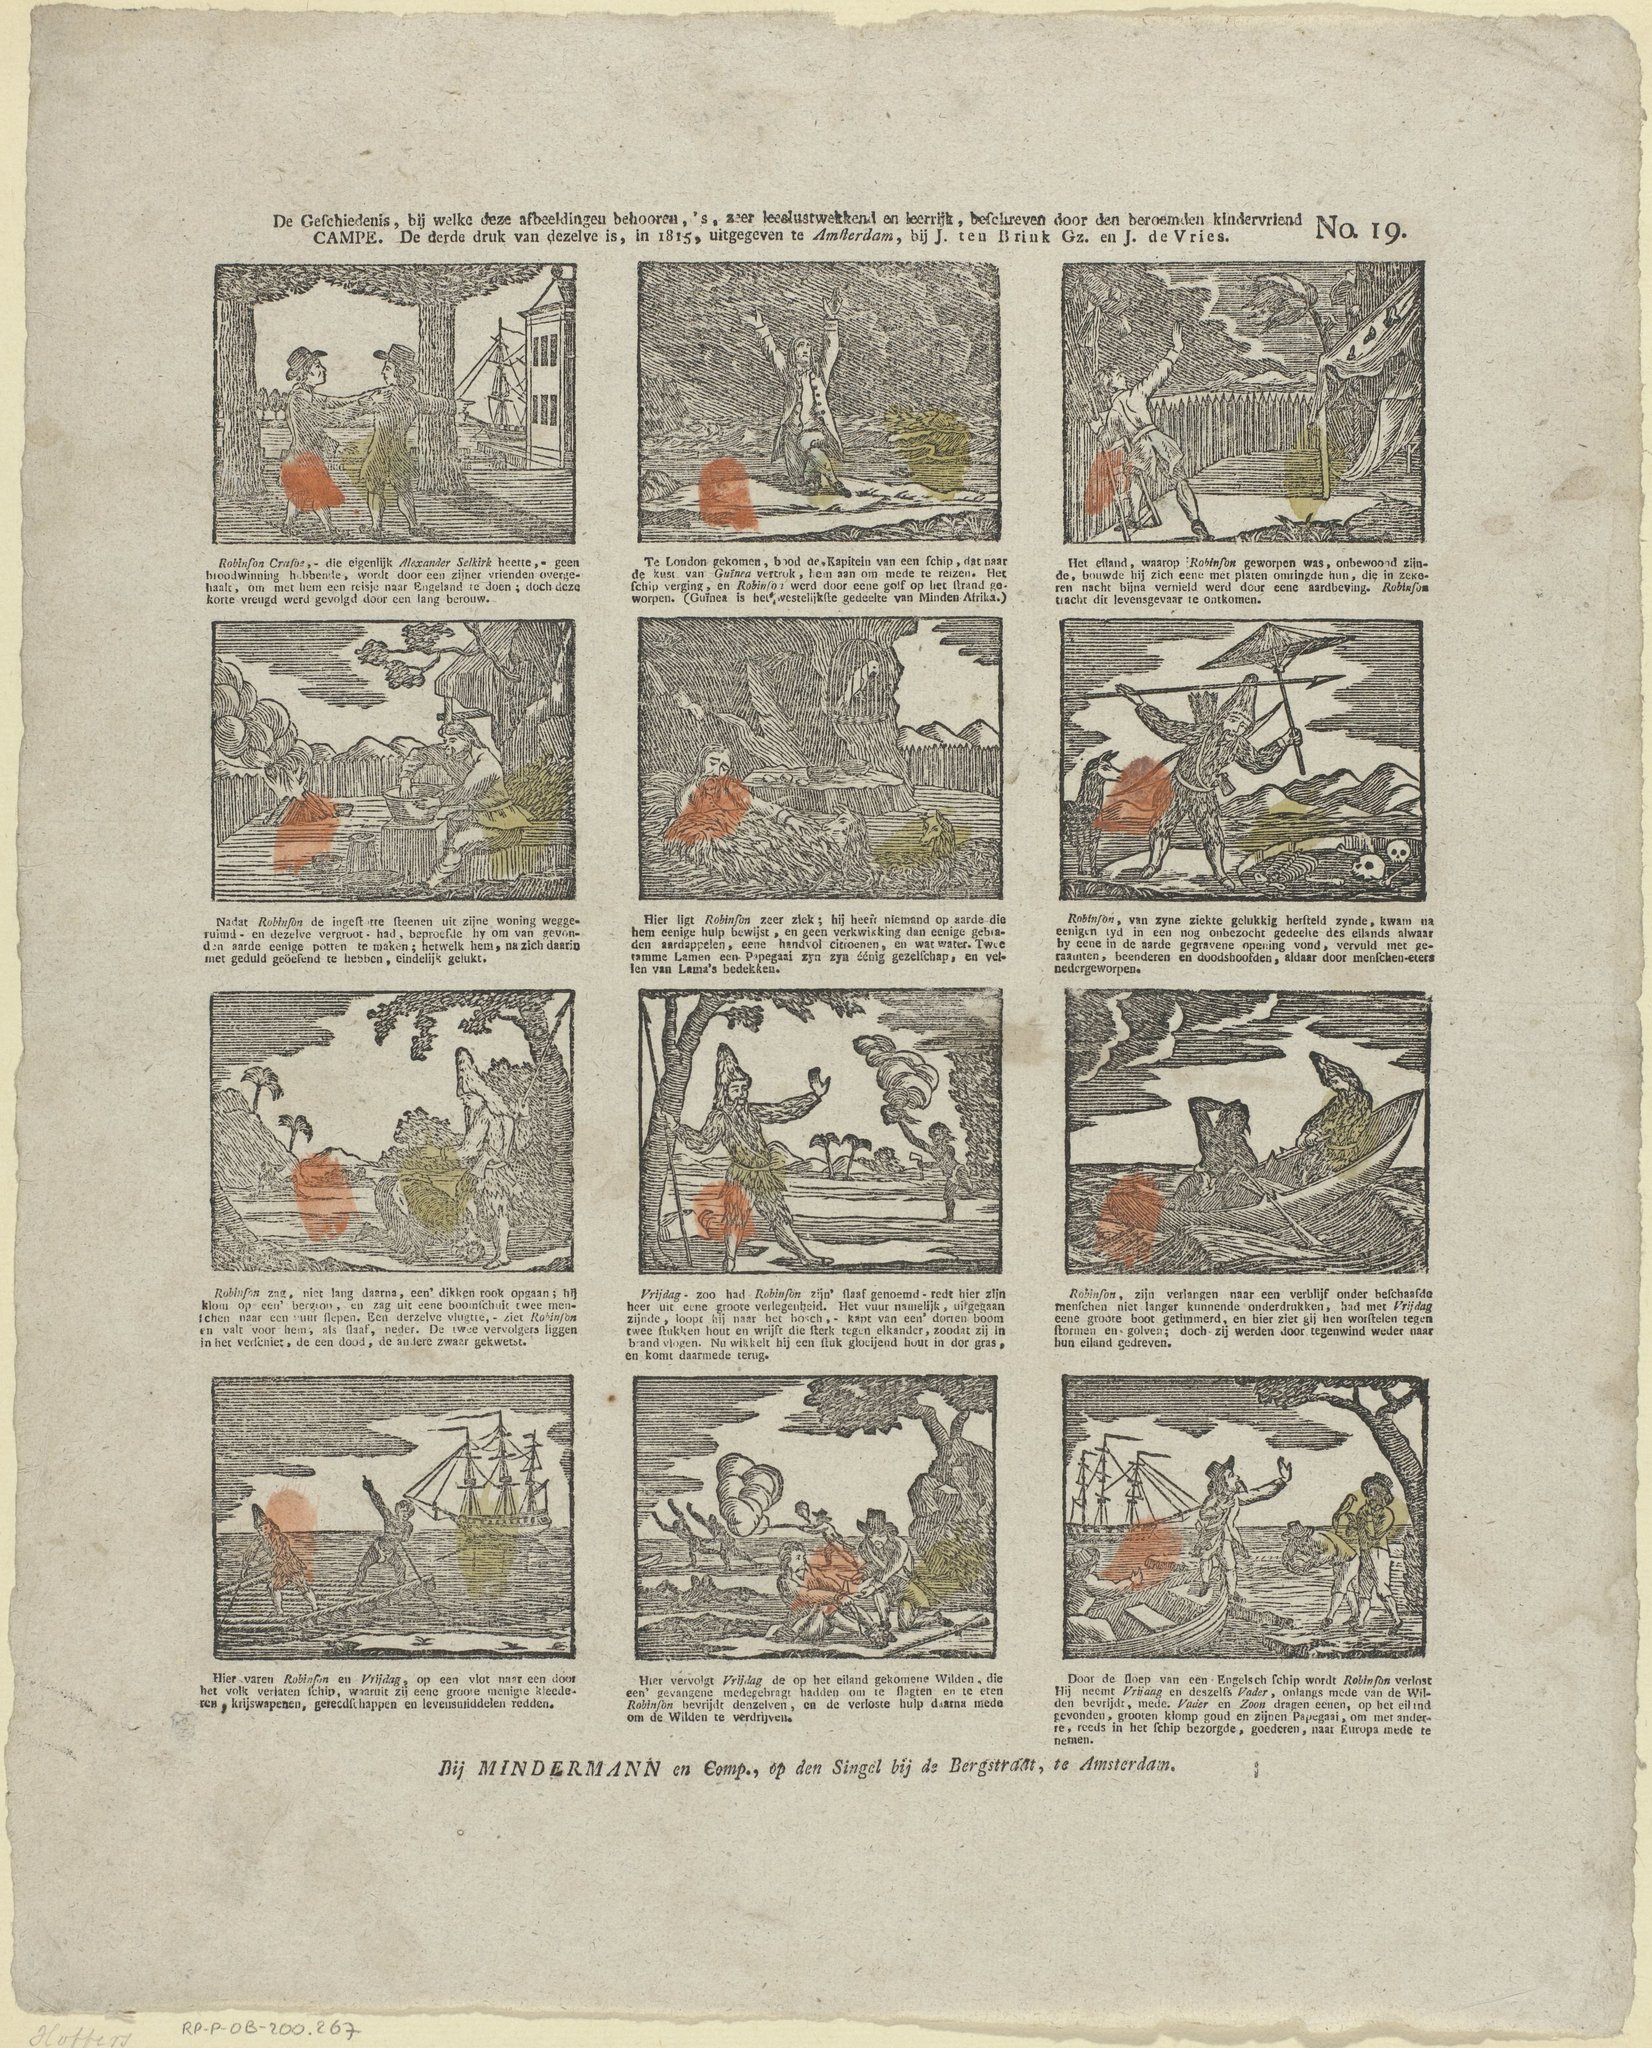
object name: popular print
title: De geschiedenis, bij welke deze afbeeldingen behooren, is, zeer leeslustwekkend en leerrijk, beschreven door den beroemden kindervriend / Camp (...)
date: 1820-1848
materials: paper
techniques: colour, letterpress printing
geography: rotterdam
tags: (scenes from) specific works of literature: defoe, robinson crusoe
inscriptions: collector's mark: Lugt 2760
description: Blad met 12 voorstellingen uit het verhaal van Robinson Crusoe die strandt op een eiland. Onder elke afbeelding een onderschrift. Genummerd rechtsboven: No. 19.